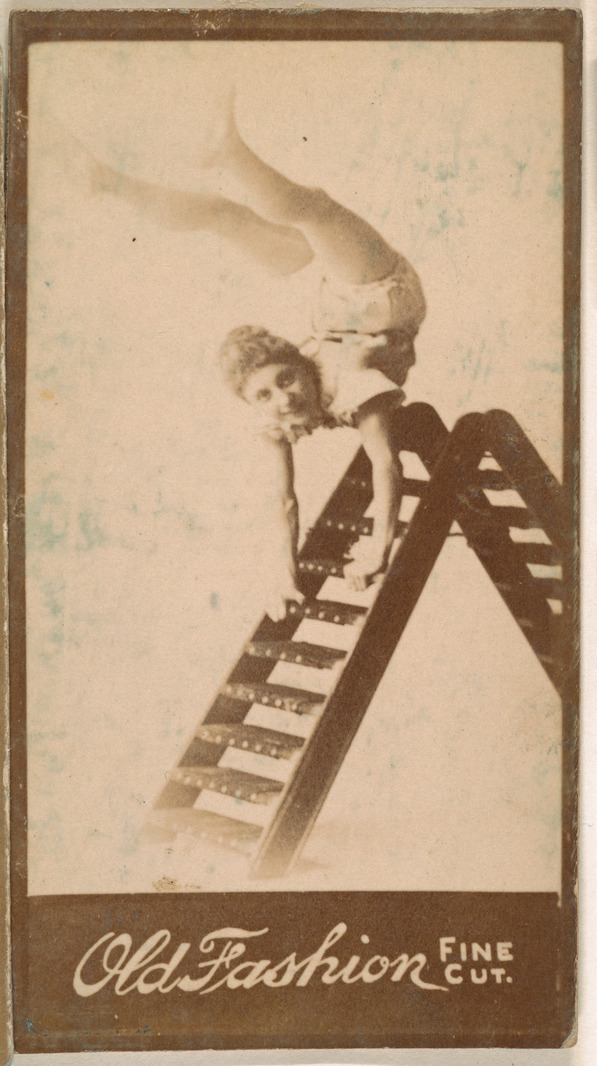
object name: photograph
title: Acrobat, from the Actresses series (N664) promoting Old Fashion Fine Cut Tobacco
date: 1888-1890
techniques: albumen silver print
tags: portraits,women,acrobats